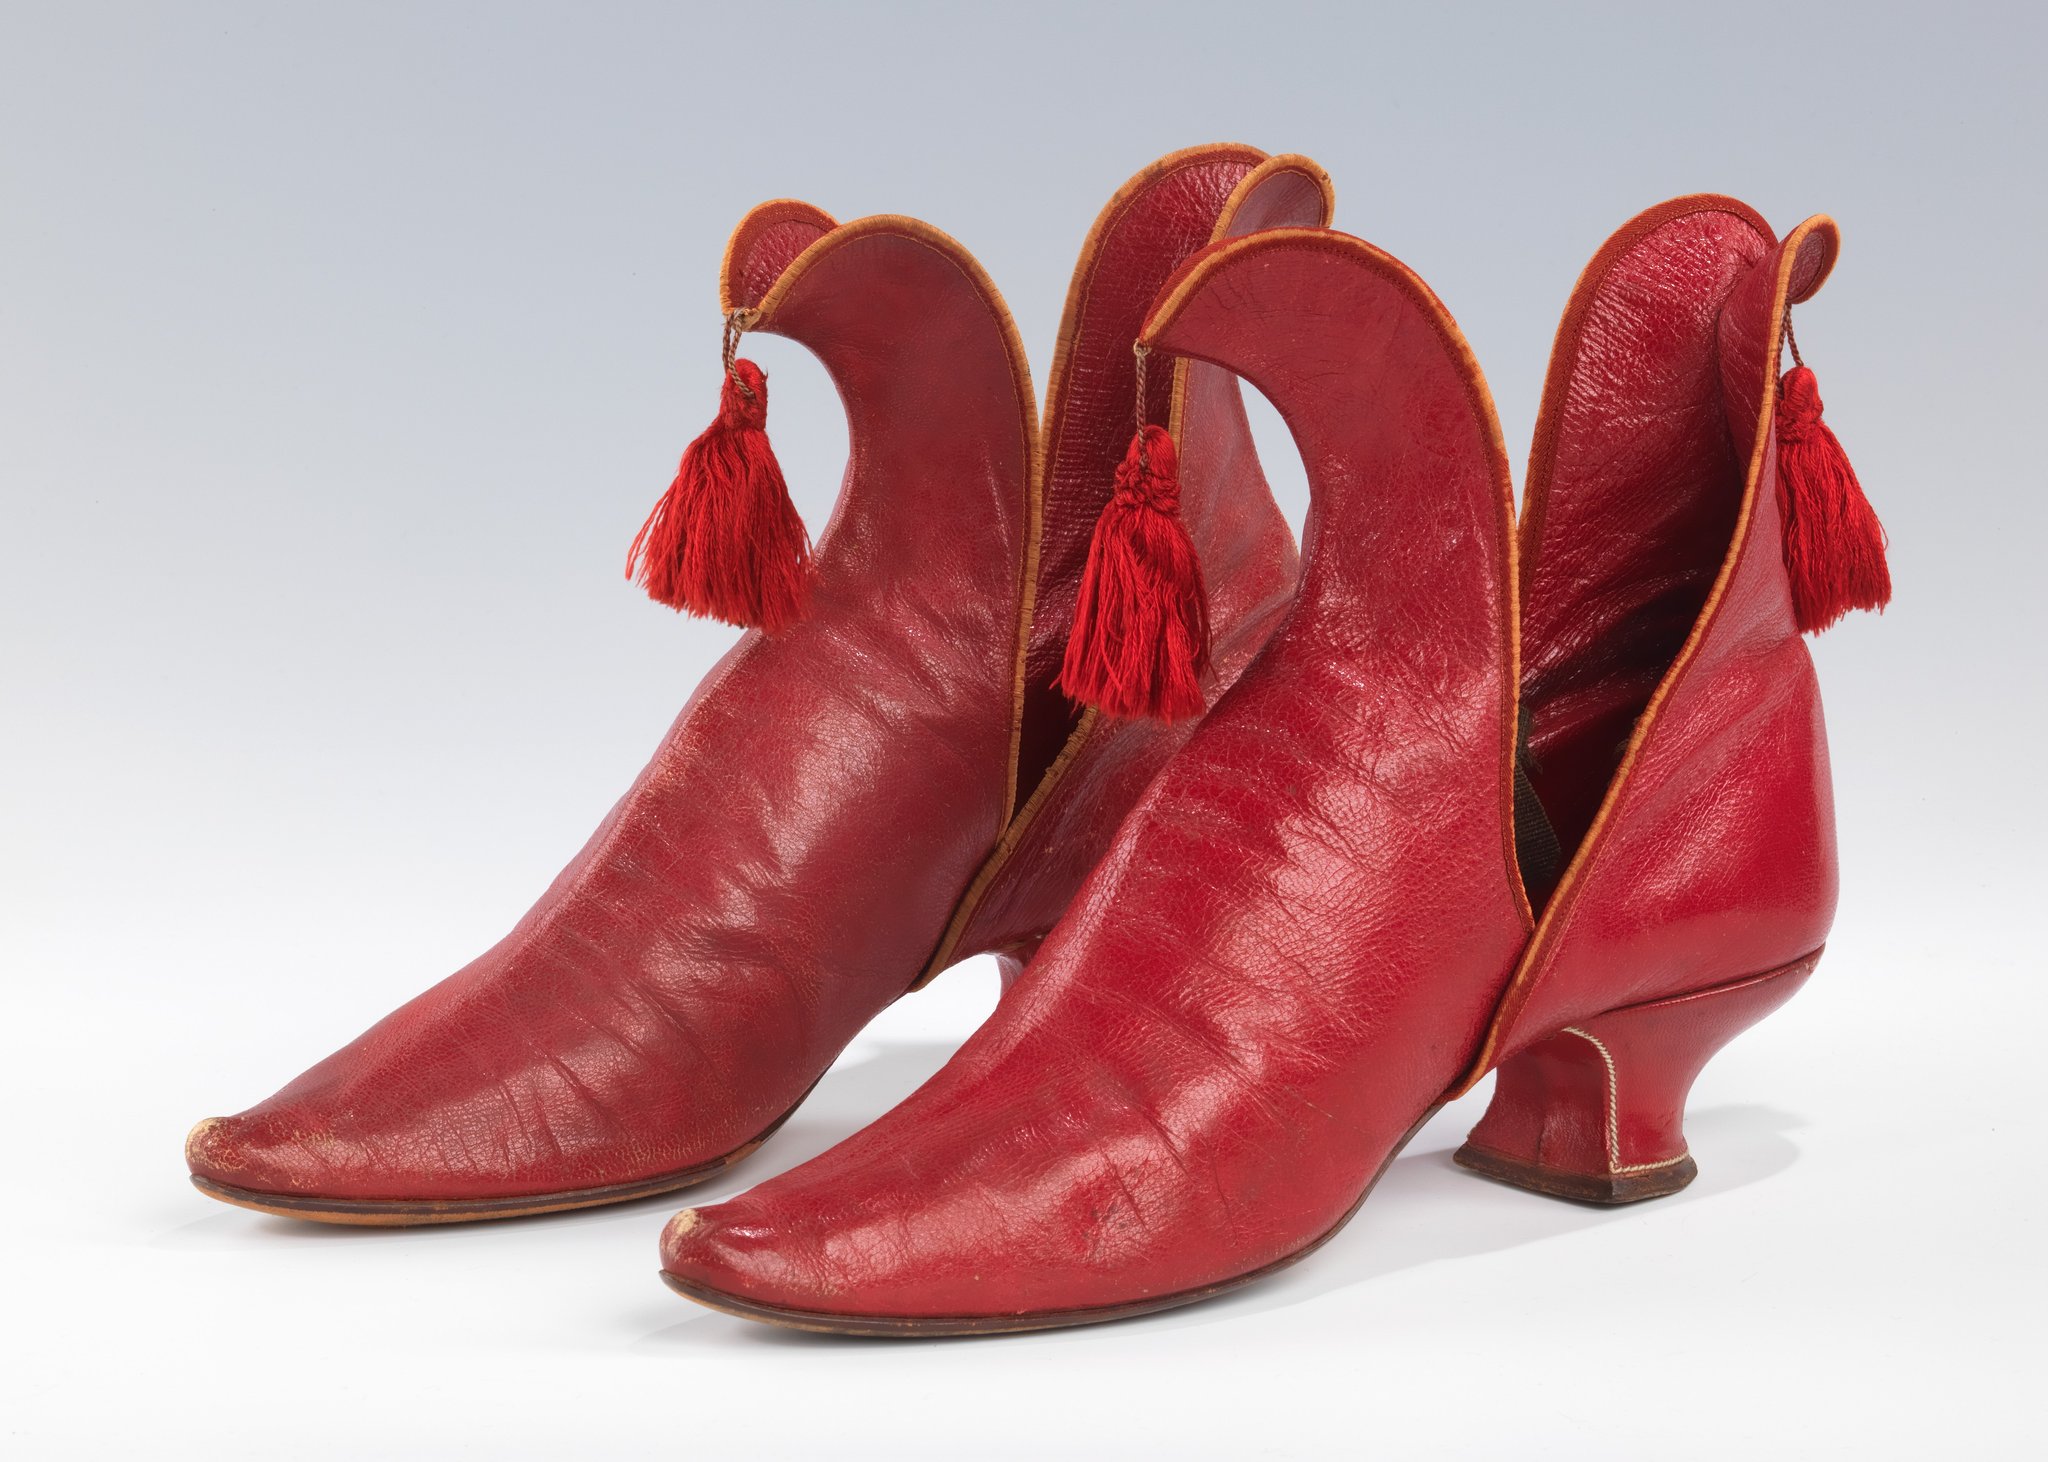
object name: slipper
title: Slippers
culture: american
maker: rosenbloom's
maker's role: department store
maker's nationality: american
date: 1892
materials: leather